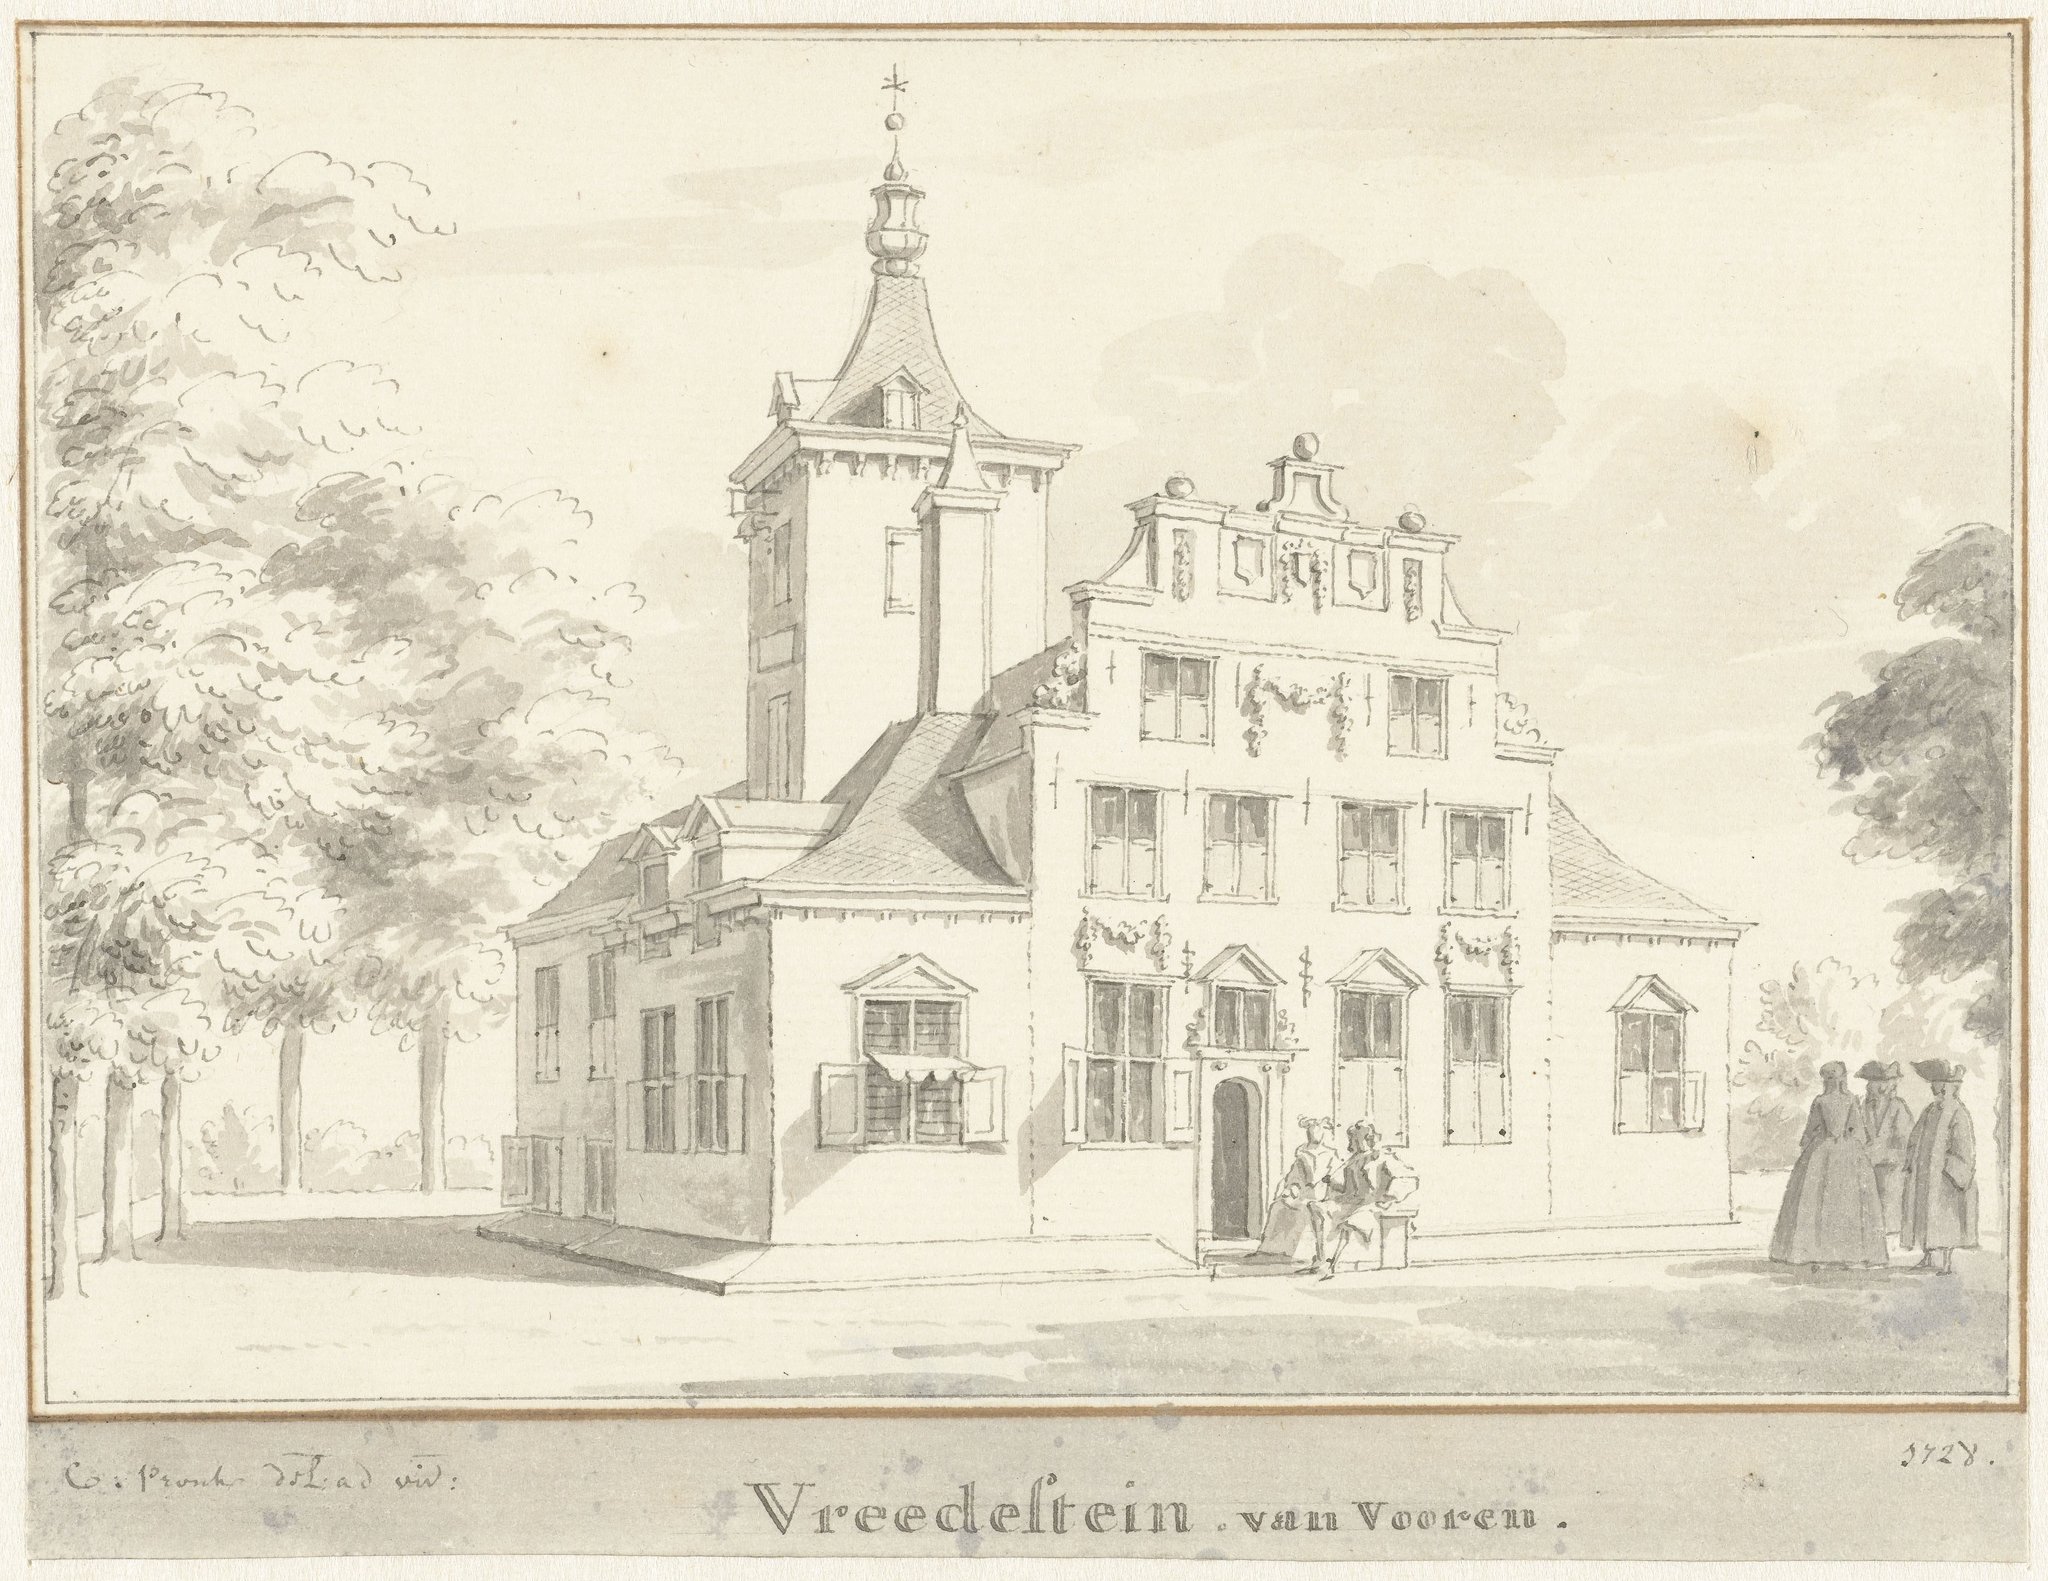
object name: drawing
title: Het huis Vredestein bij Ravenswaaij, Gelderland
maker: cornelis pronk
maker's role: draughtsman, painter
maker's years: 1691-1759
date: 1728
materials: ink, paper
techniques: brush, pen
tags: castle, rural housing, e.g. country-house, villa, cottage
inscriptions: inscription: ‘C: Pronk del: ad viv: / Vreedestein van Vooren / 1728’